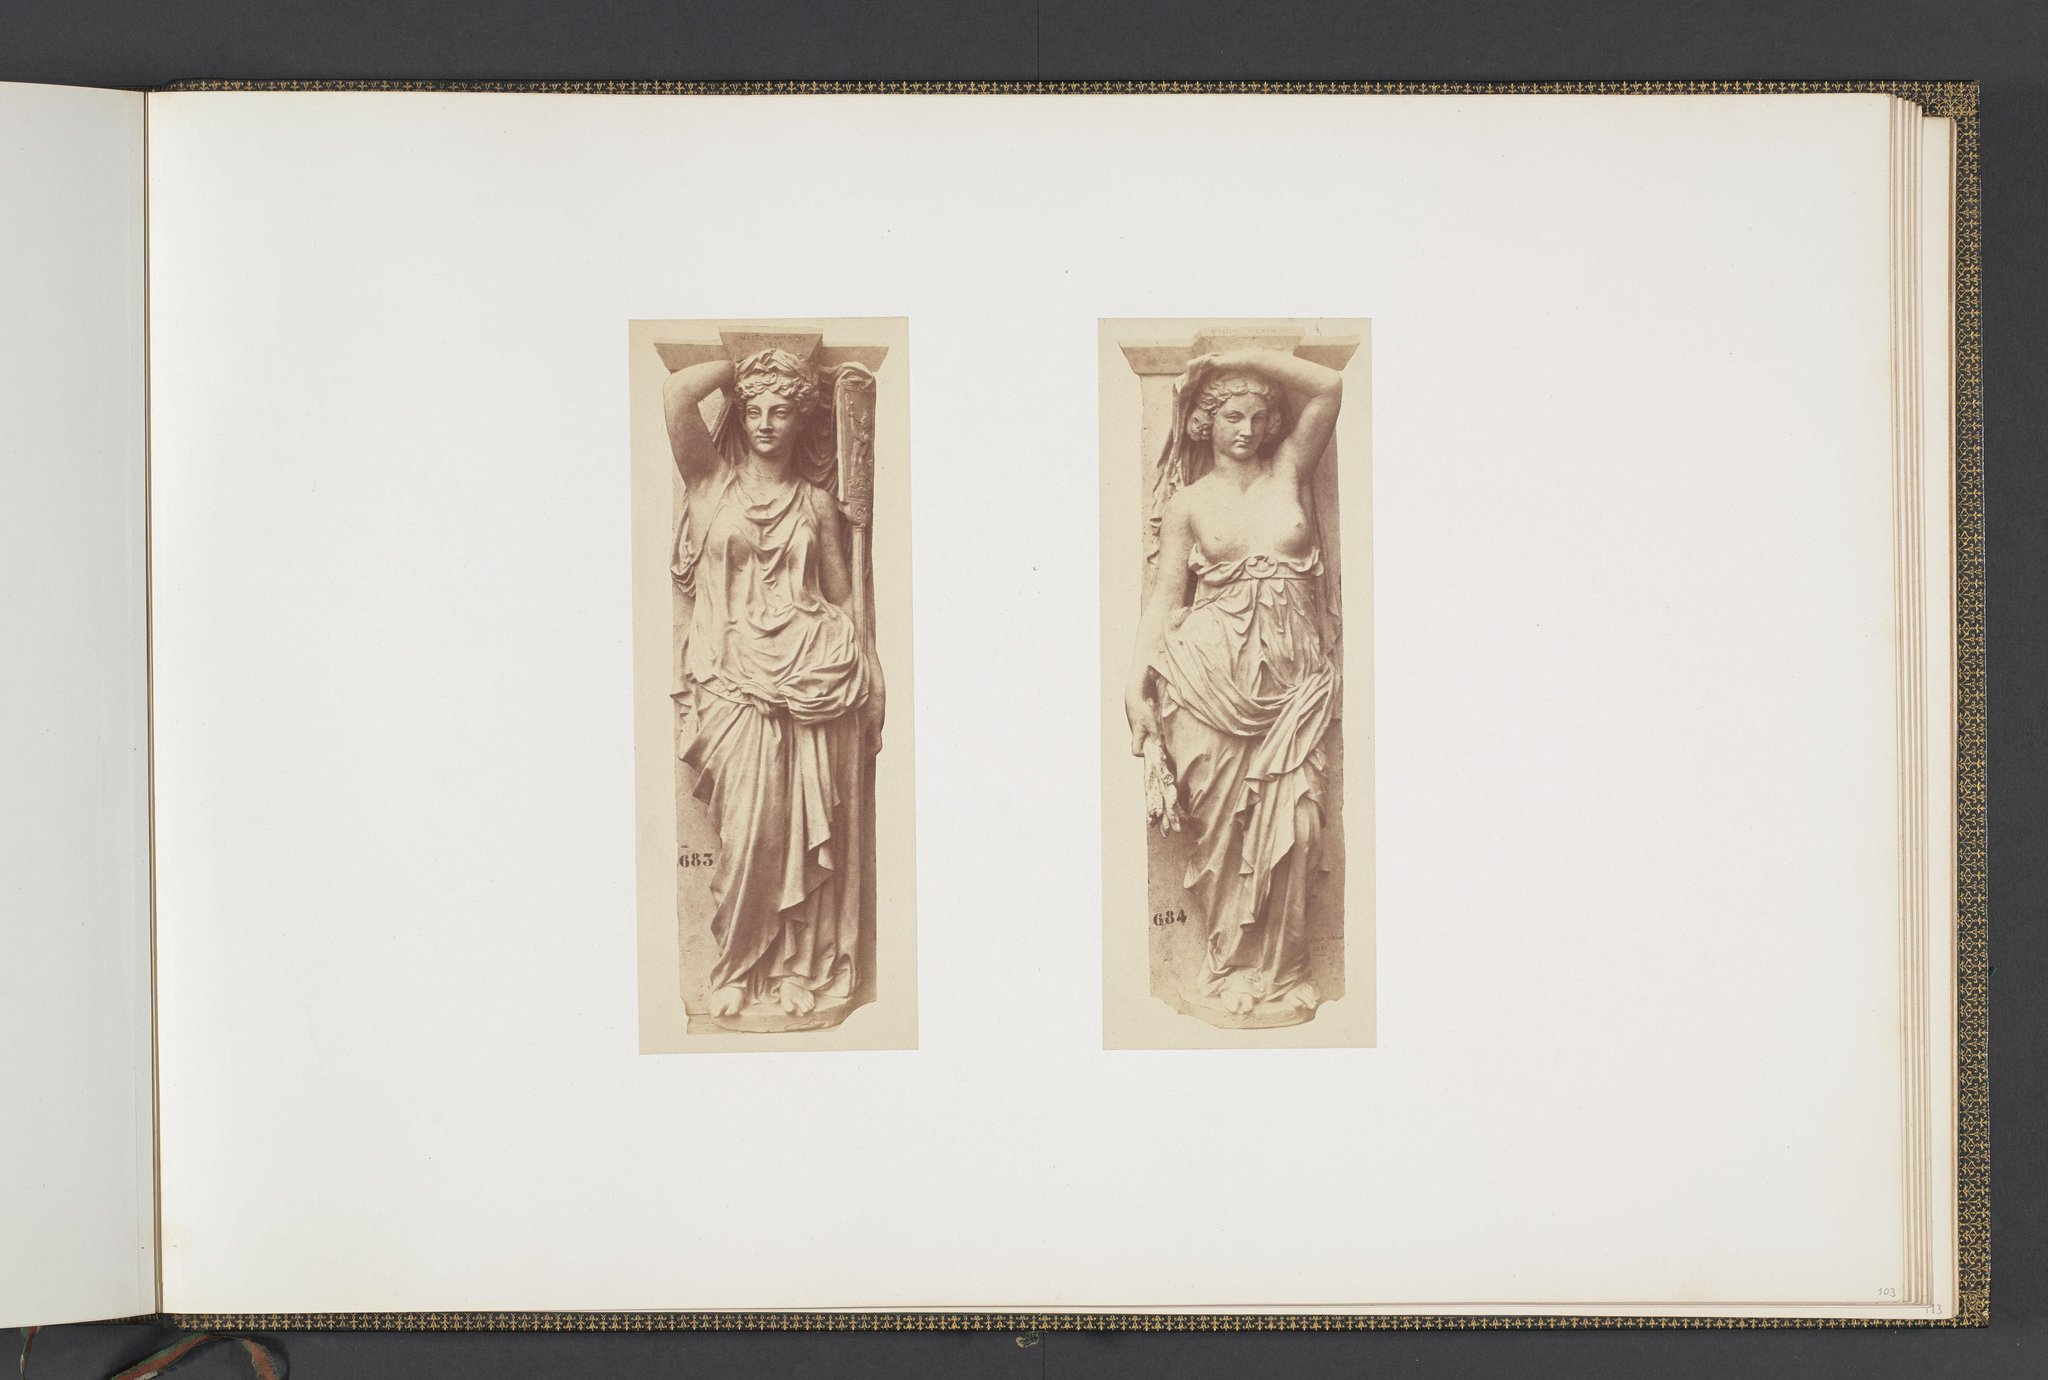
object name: album leaf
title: Gipsmodellen voor kariatiden op het Palais du Louvre door Victor Vilain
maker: édouard denis baldus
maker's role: fotograaf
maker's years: 1813-1889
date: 1855-1857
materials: paper, photographic support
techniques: salted paper print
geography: paris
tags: caryatids ~ architecture, permanent exhibition, museum, paris, tuileries palace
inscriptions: number: ‘683 en 684’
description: Onderdeel van Réunion des Tuileries au Louvre 1852-1857, album 1.